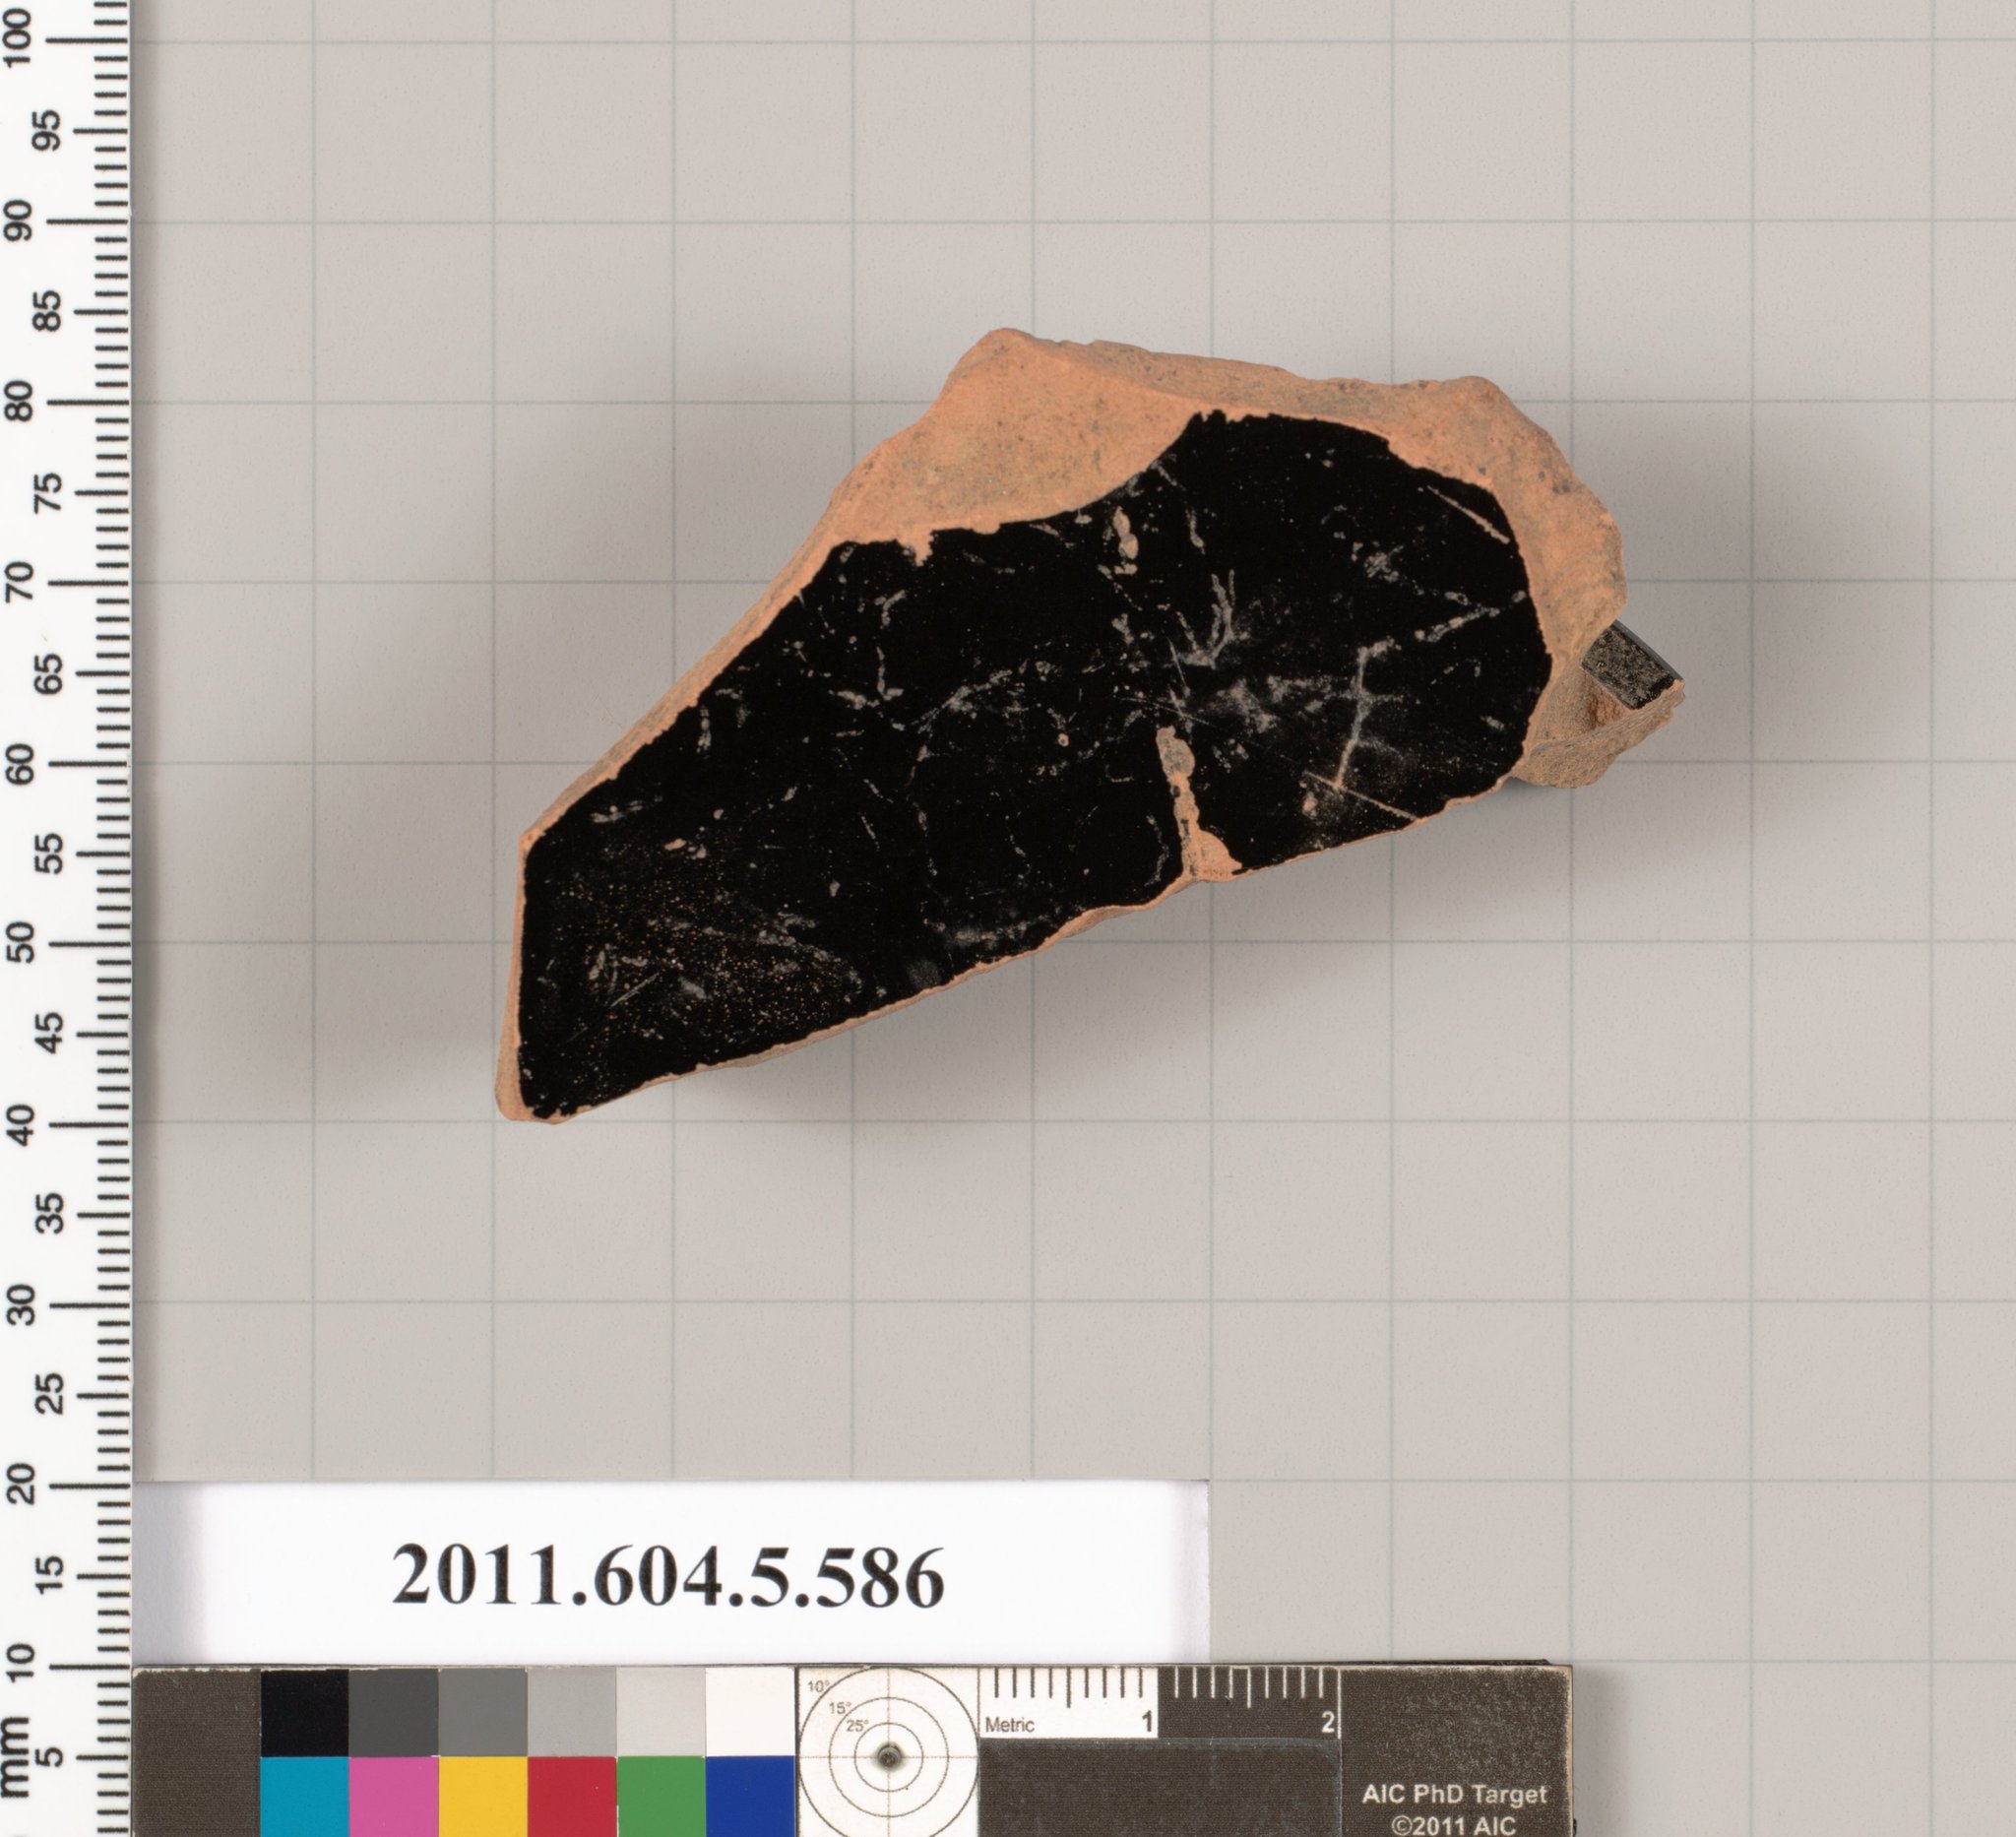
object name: stemless kylix fragment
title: Terracotta fragment of a stemless kylix (drinking cup)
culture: greek, attic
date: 600-401 BCE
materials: terracotta